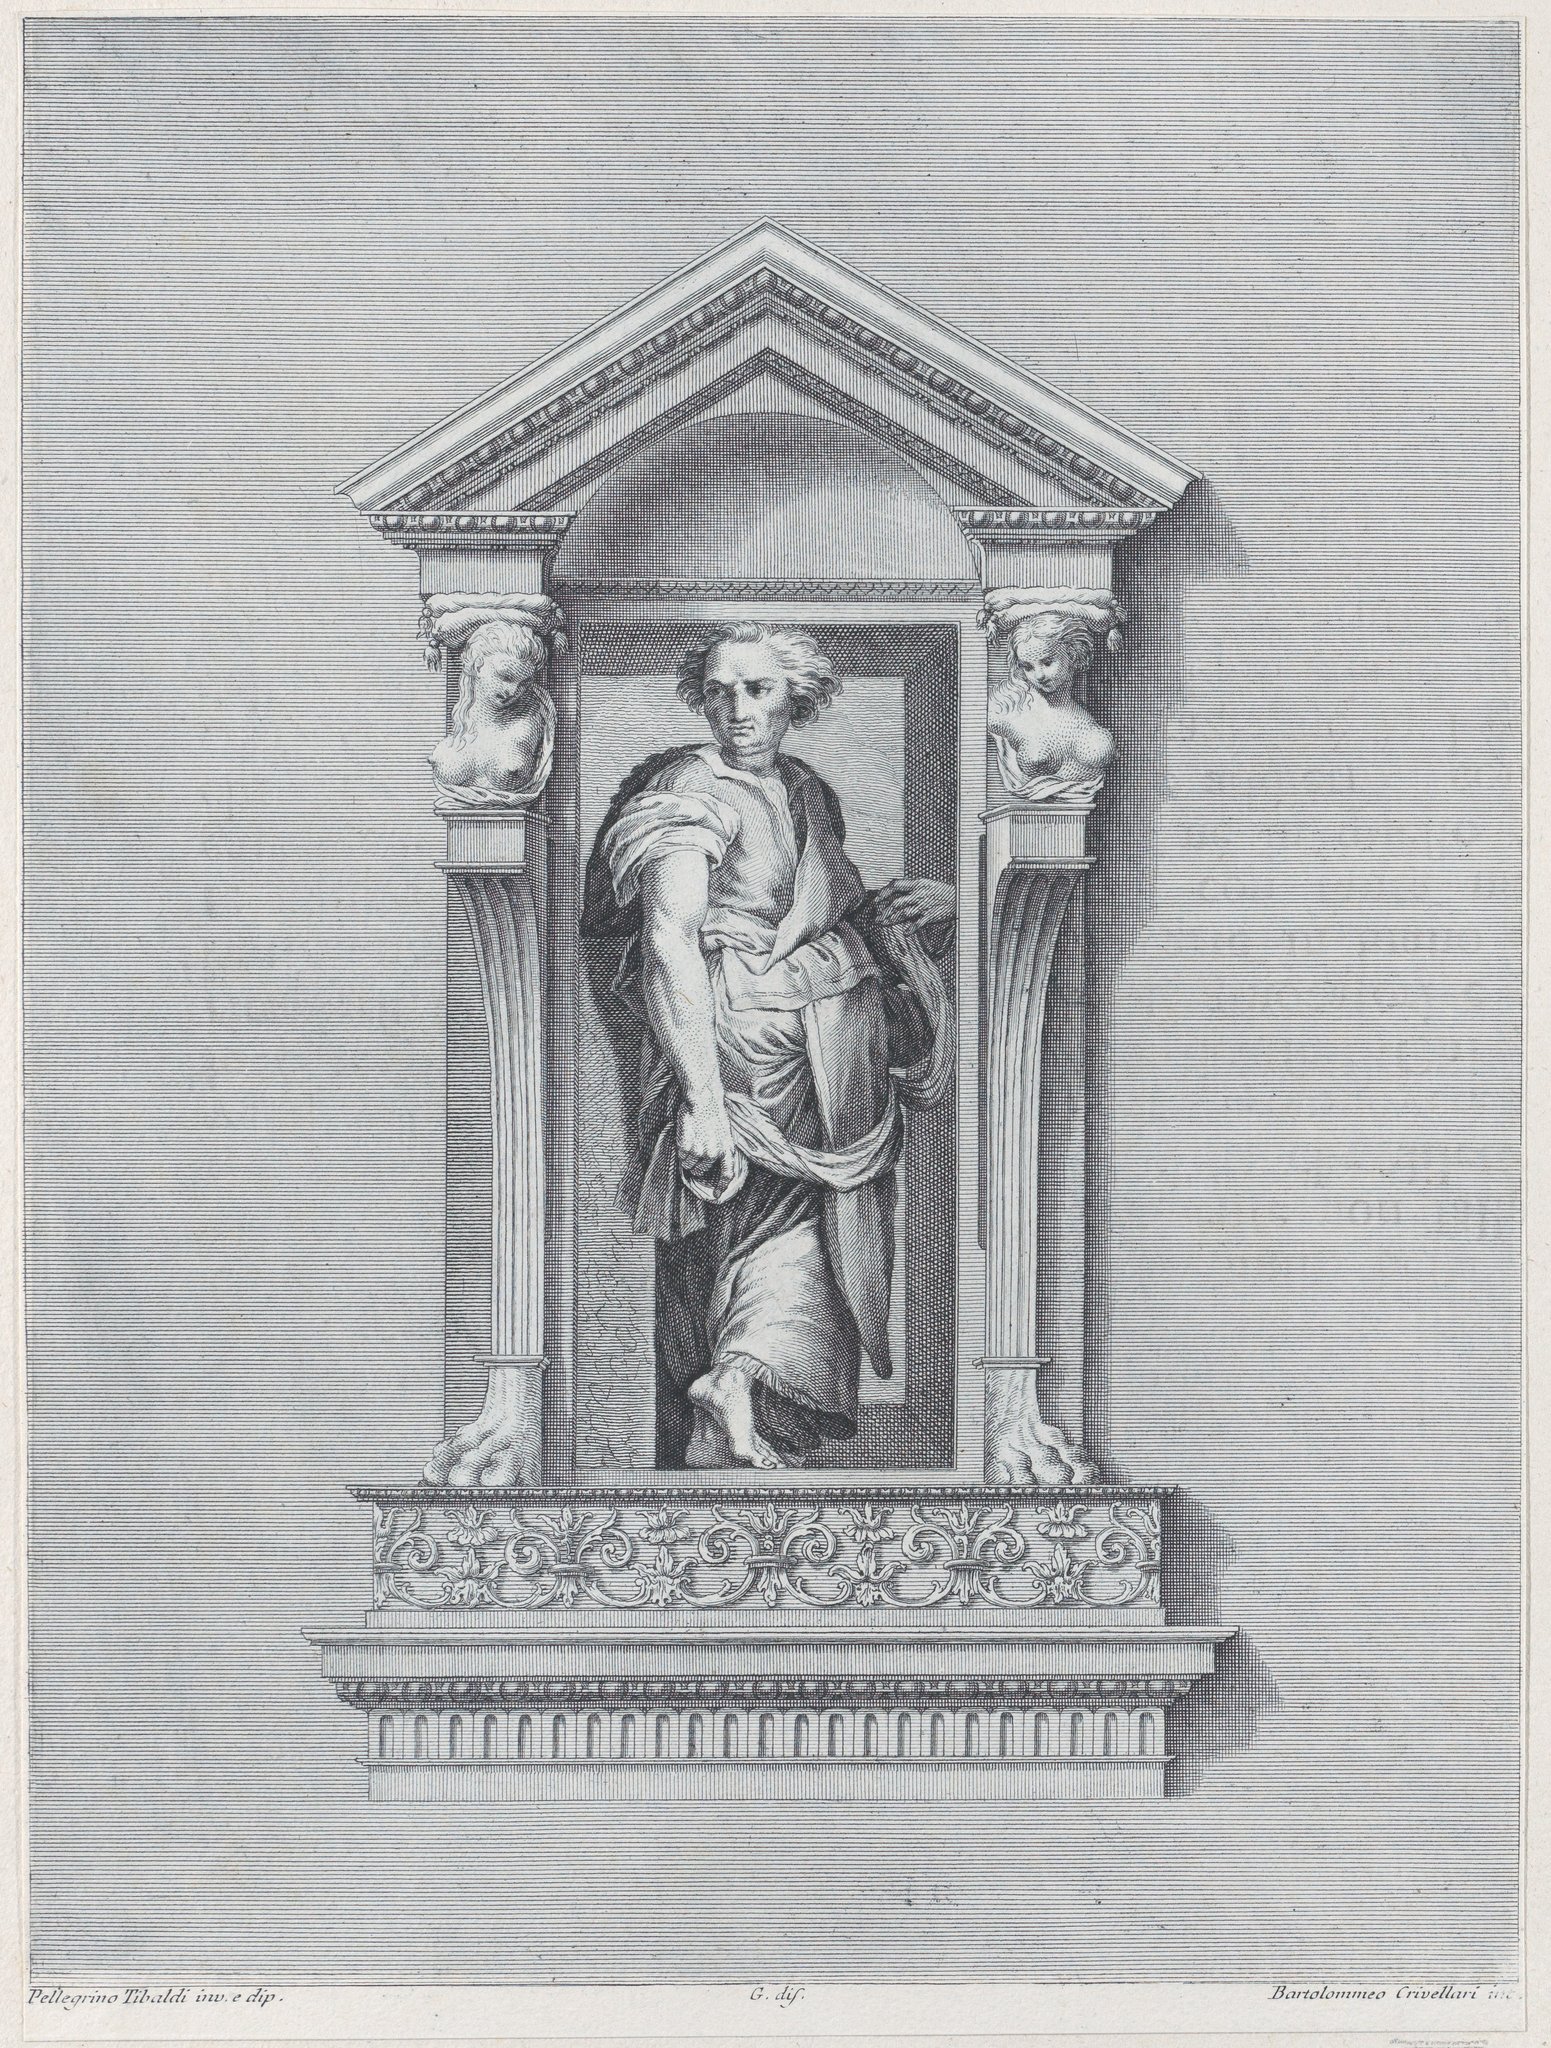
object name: print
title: A standing man in a niche looking toward the left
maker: bartolomeo crivellari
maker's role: artist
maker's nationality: italian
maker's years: 1700-1800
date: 1756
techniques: engraving, etching